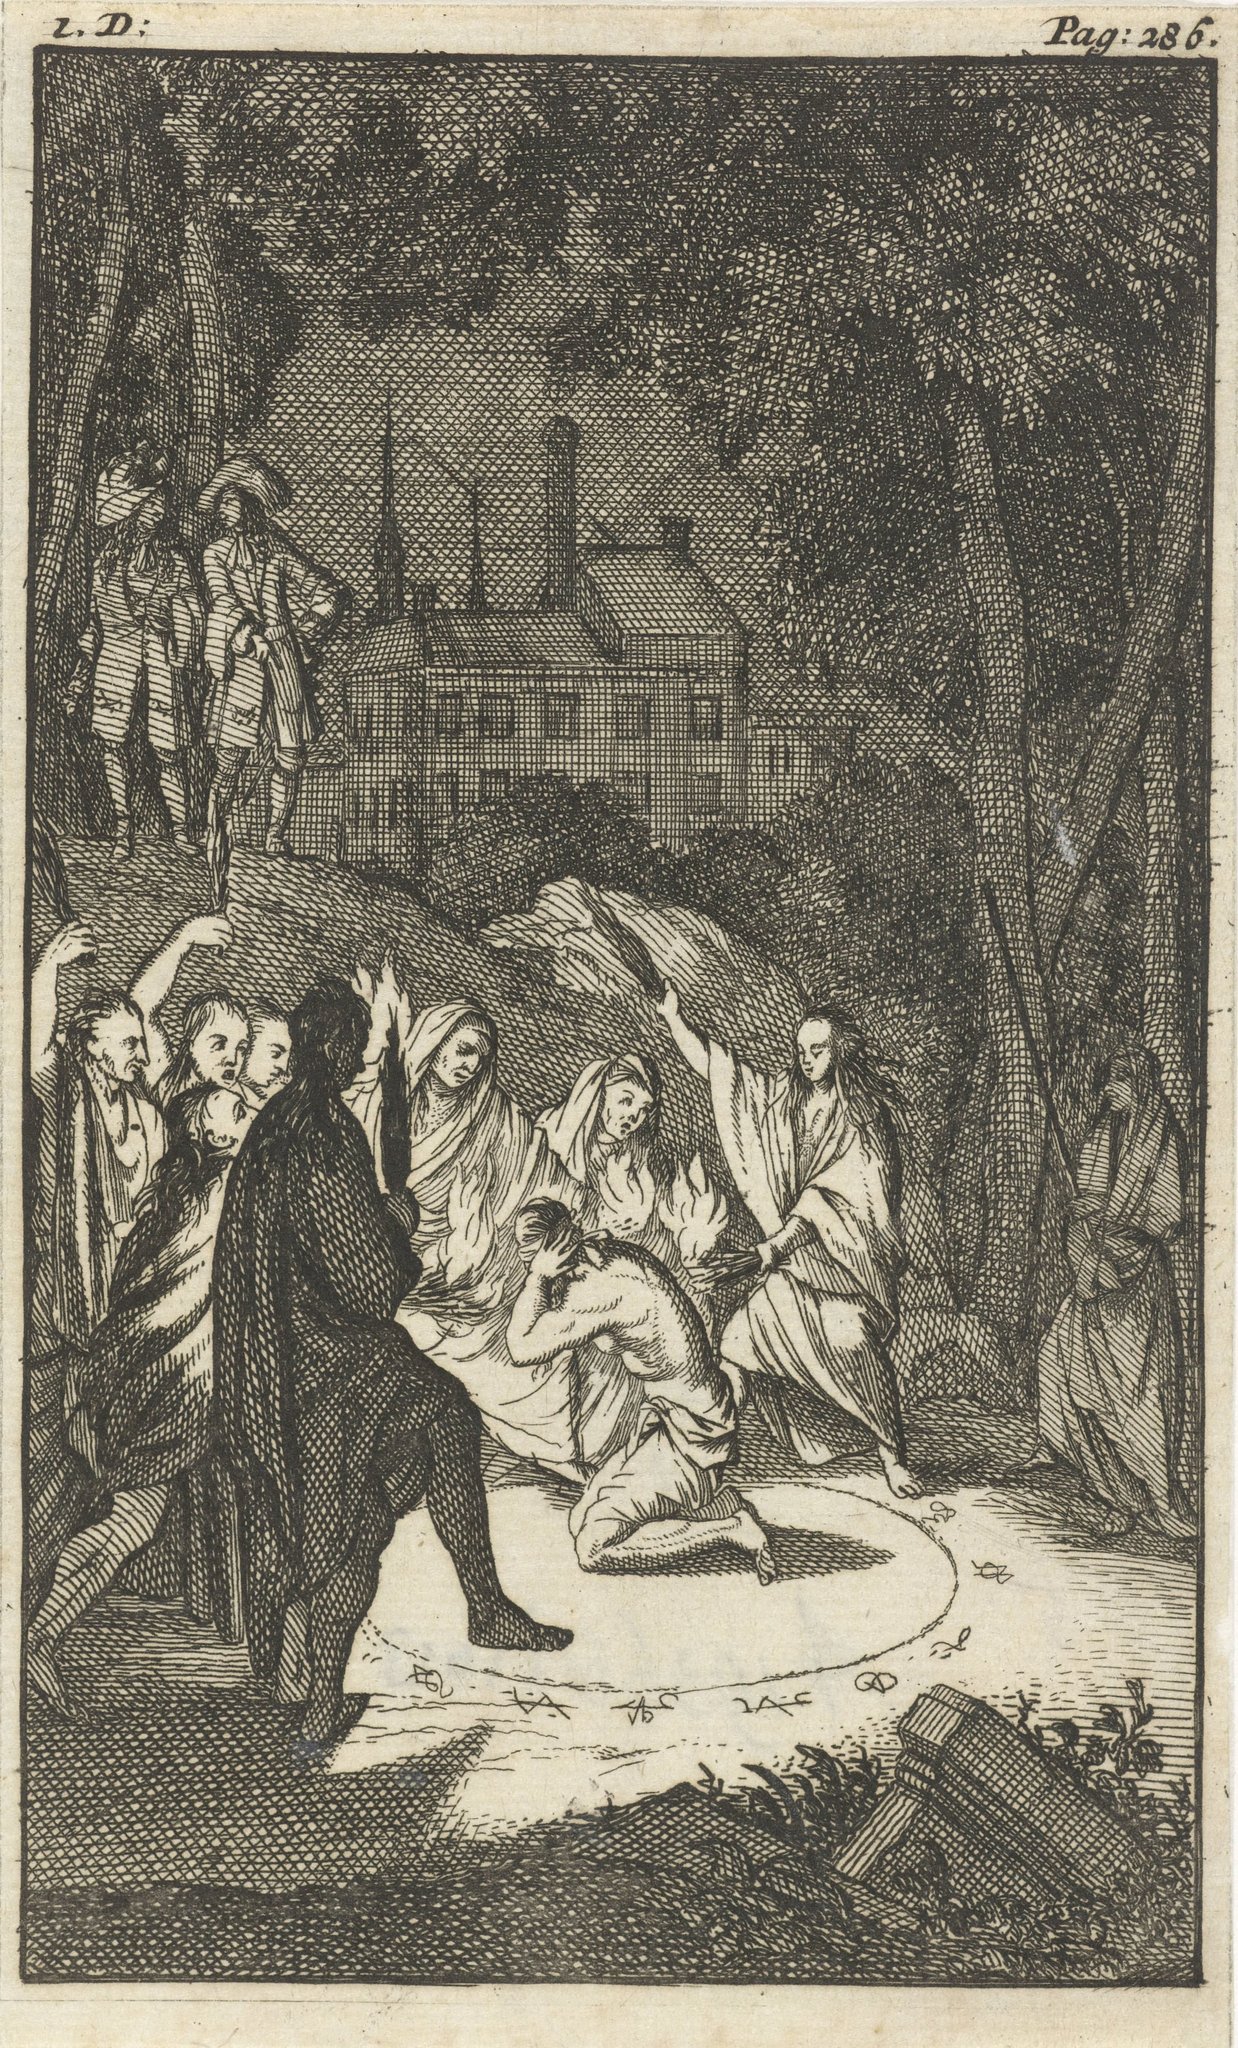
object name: print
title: Simon, de verliefde kok, bij de waarzegster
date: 1695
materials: paper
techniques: etching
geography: amsterdam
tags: fortune-teller ~ pleasure fair and circus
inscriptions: collector's mark: Lugt 2228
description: Illustratie uit: Heinsius, Nicolaas jr. Den vermakelyken avanturier, ofte De wispelturige, en niet min wonderlyke levens-loop van Mirandor, 2 delen. Amsterdam: Pieter van Amsterdam, 1695, dl. I.